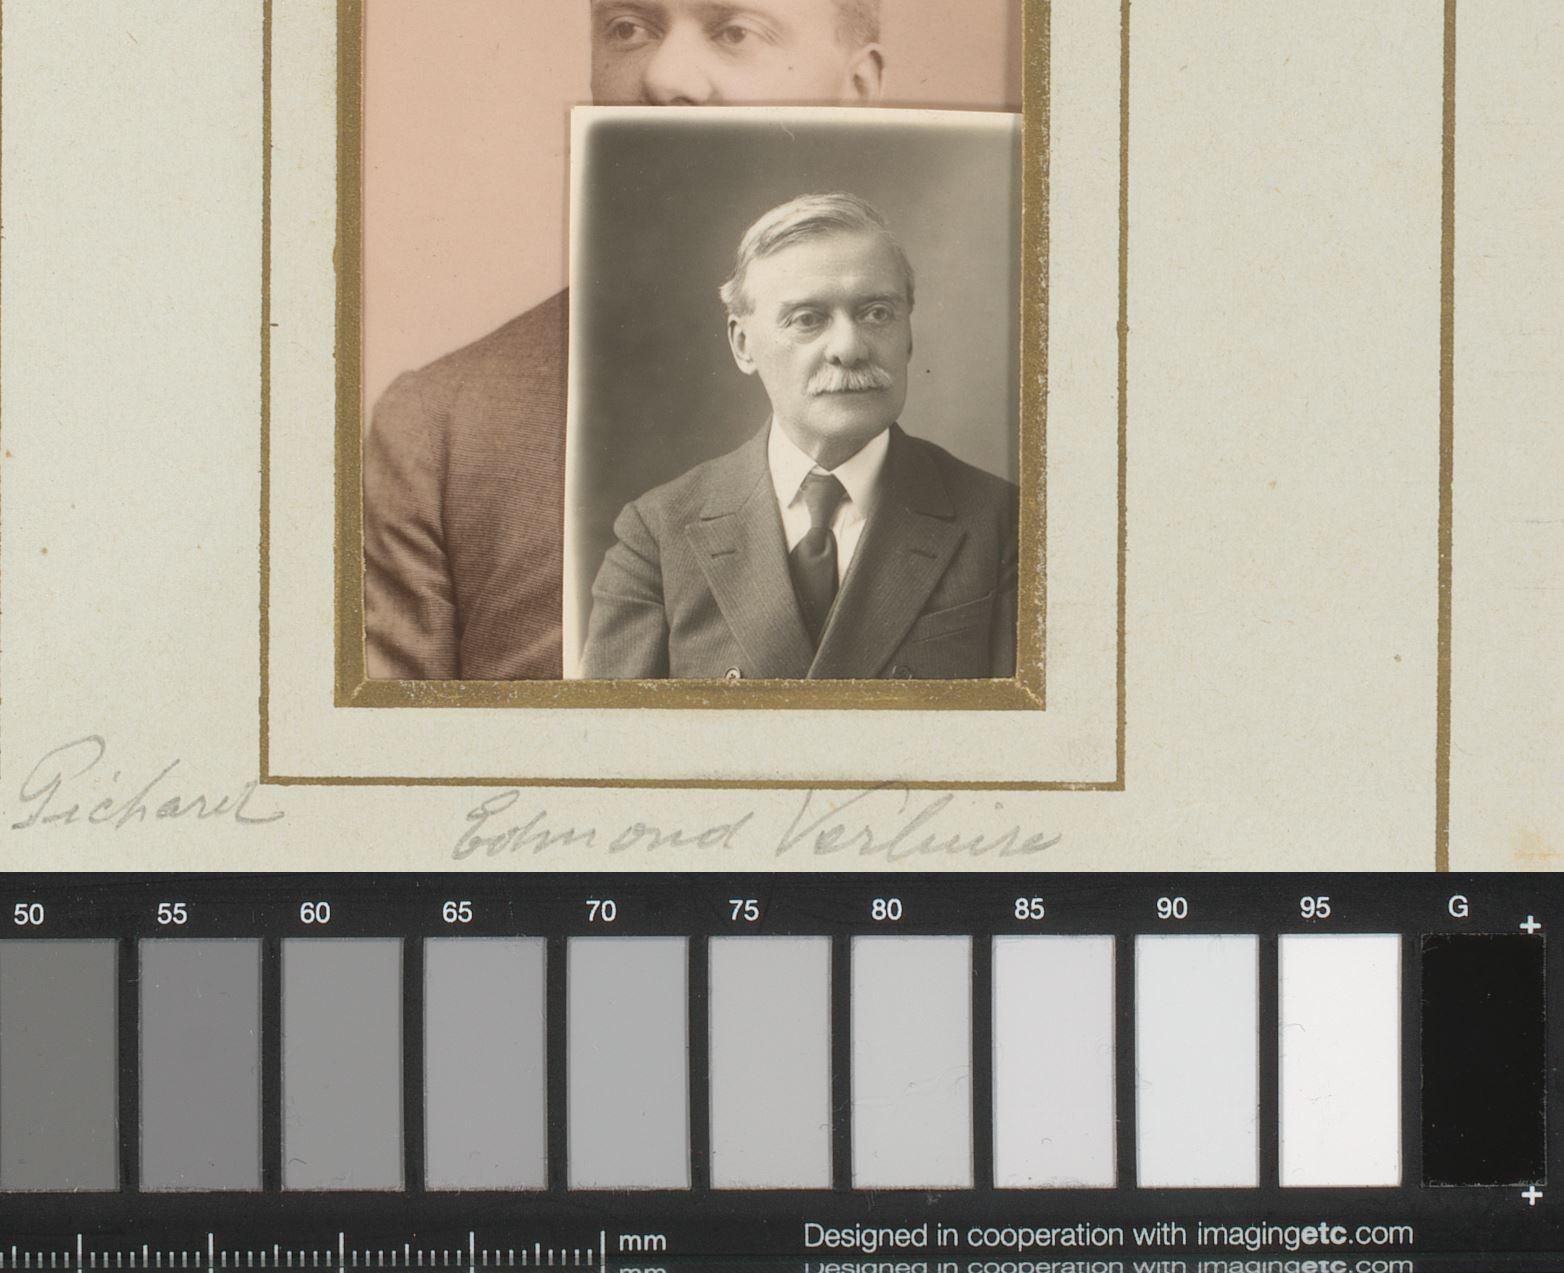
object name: album leaf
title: Portret van Edmond Verluise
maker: emile graffe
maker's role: painter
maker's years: 1846-1894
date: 1880-1920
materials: cardboard, photographic support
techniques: collodion silver print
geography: paris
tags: historical persons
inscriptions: name: ‘Edmond Verluise’, inscription: ‘PHOTOGRAPHIE DES ARTS/ 11, Place St. André des Arts, 11/ PARIS/ GRAFFE/ Artiste Peintre Photographe/ Breveté S.G.D.G.’